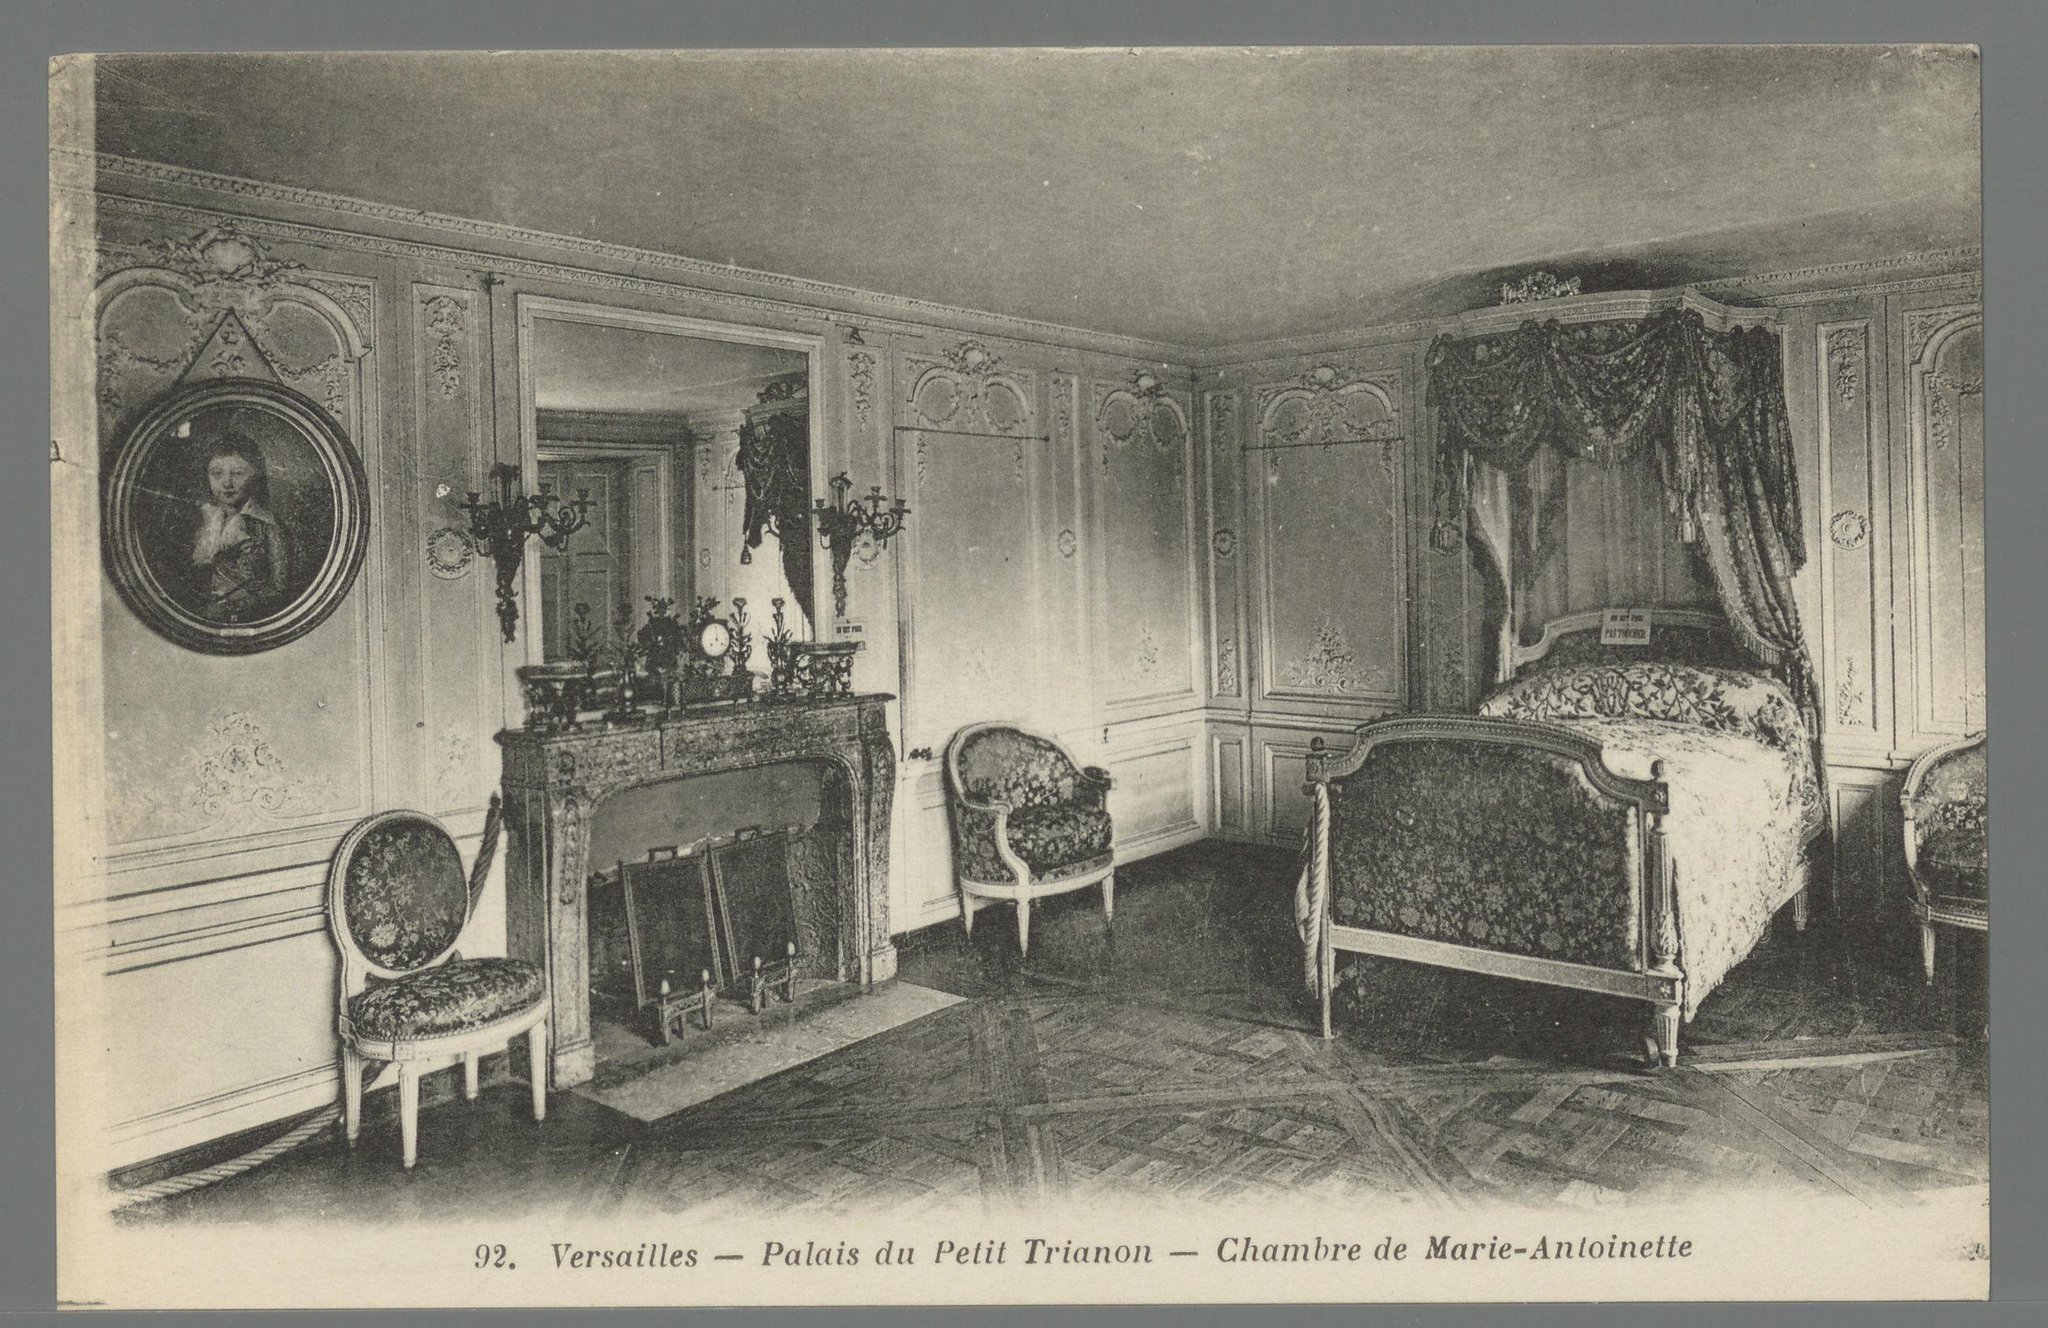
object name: photomechanical print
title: Versailles. Palais du Petit Trianon. Chambre de Marie-Antoinette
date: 1903-1920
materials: cardboard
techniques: photograph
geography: versailles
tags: palace, interior ~ representation of a building, bedroom